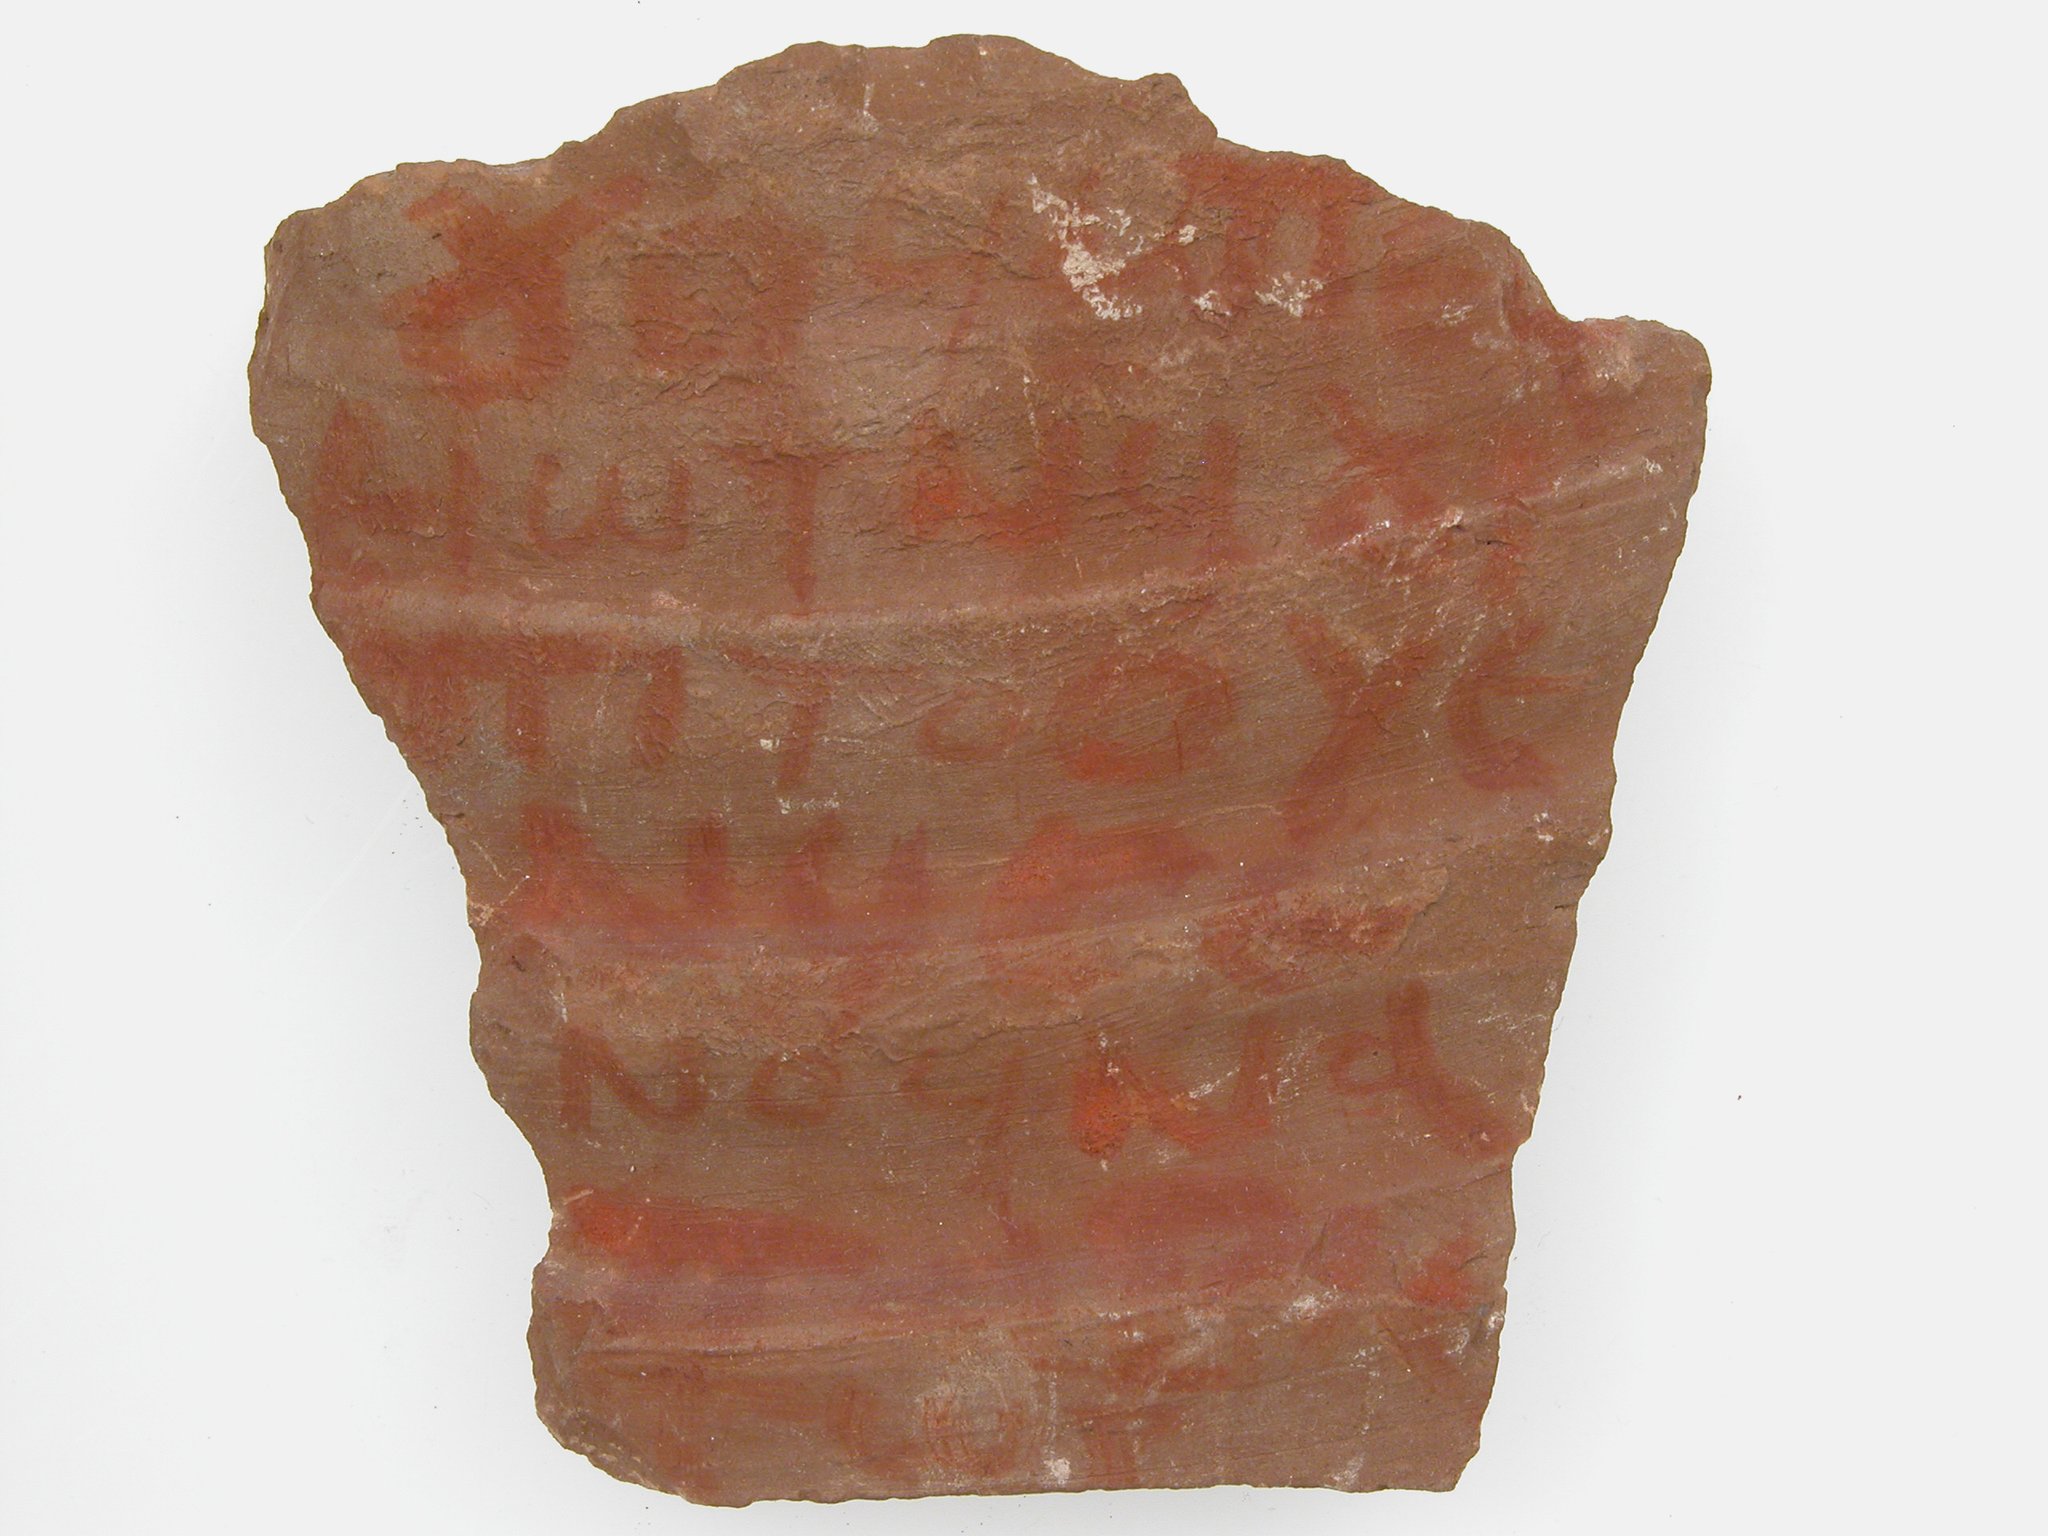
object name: ostrakon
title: Ostrakon with a Letter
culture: coptic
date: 600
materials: ink, pottery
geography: egypt